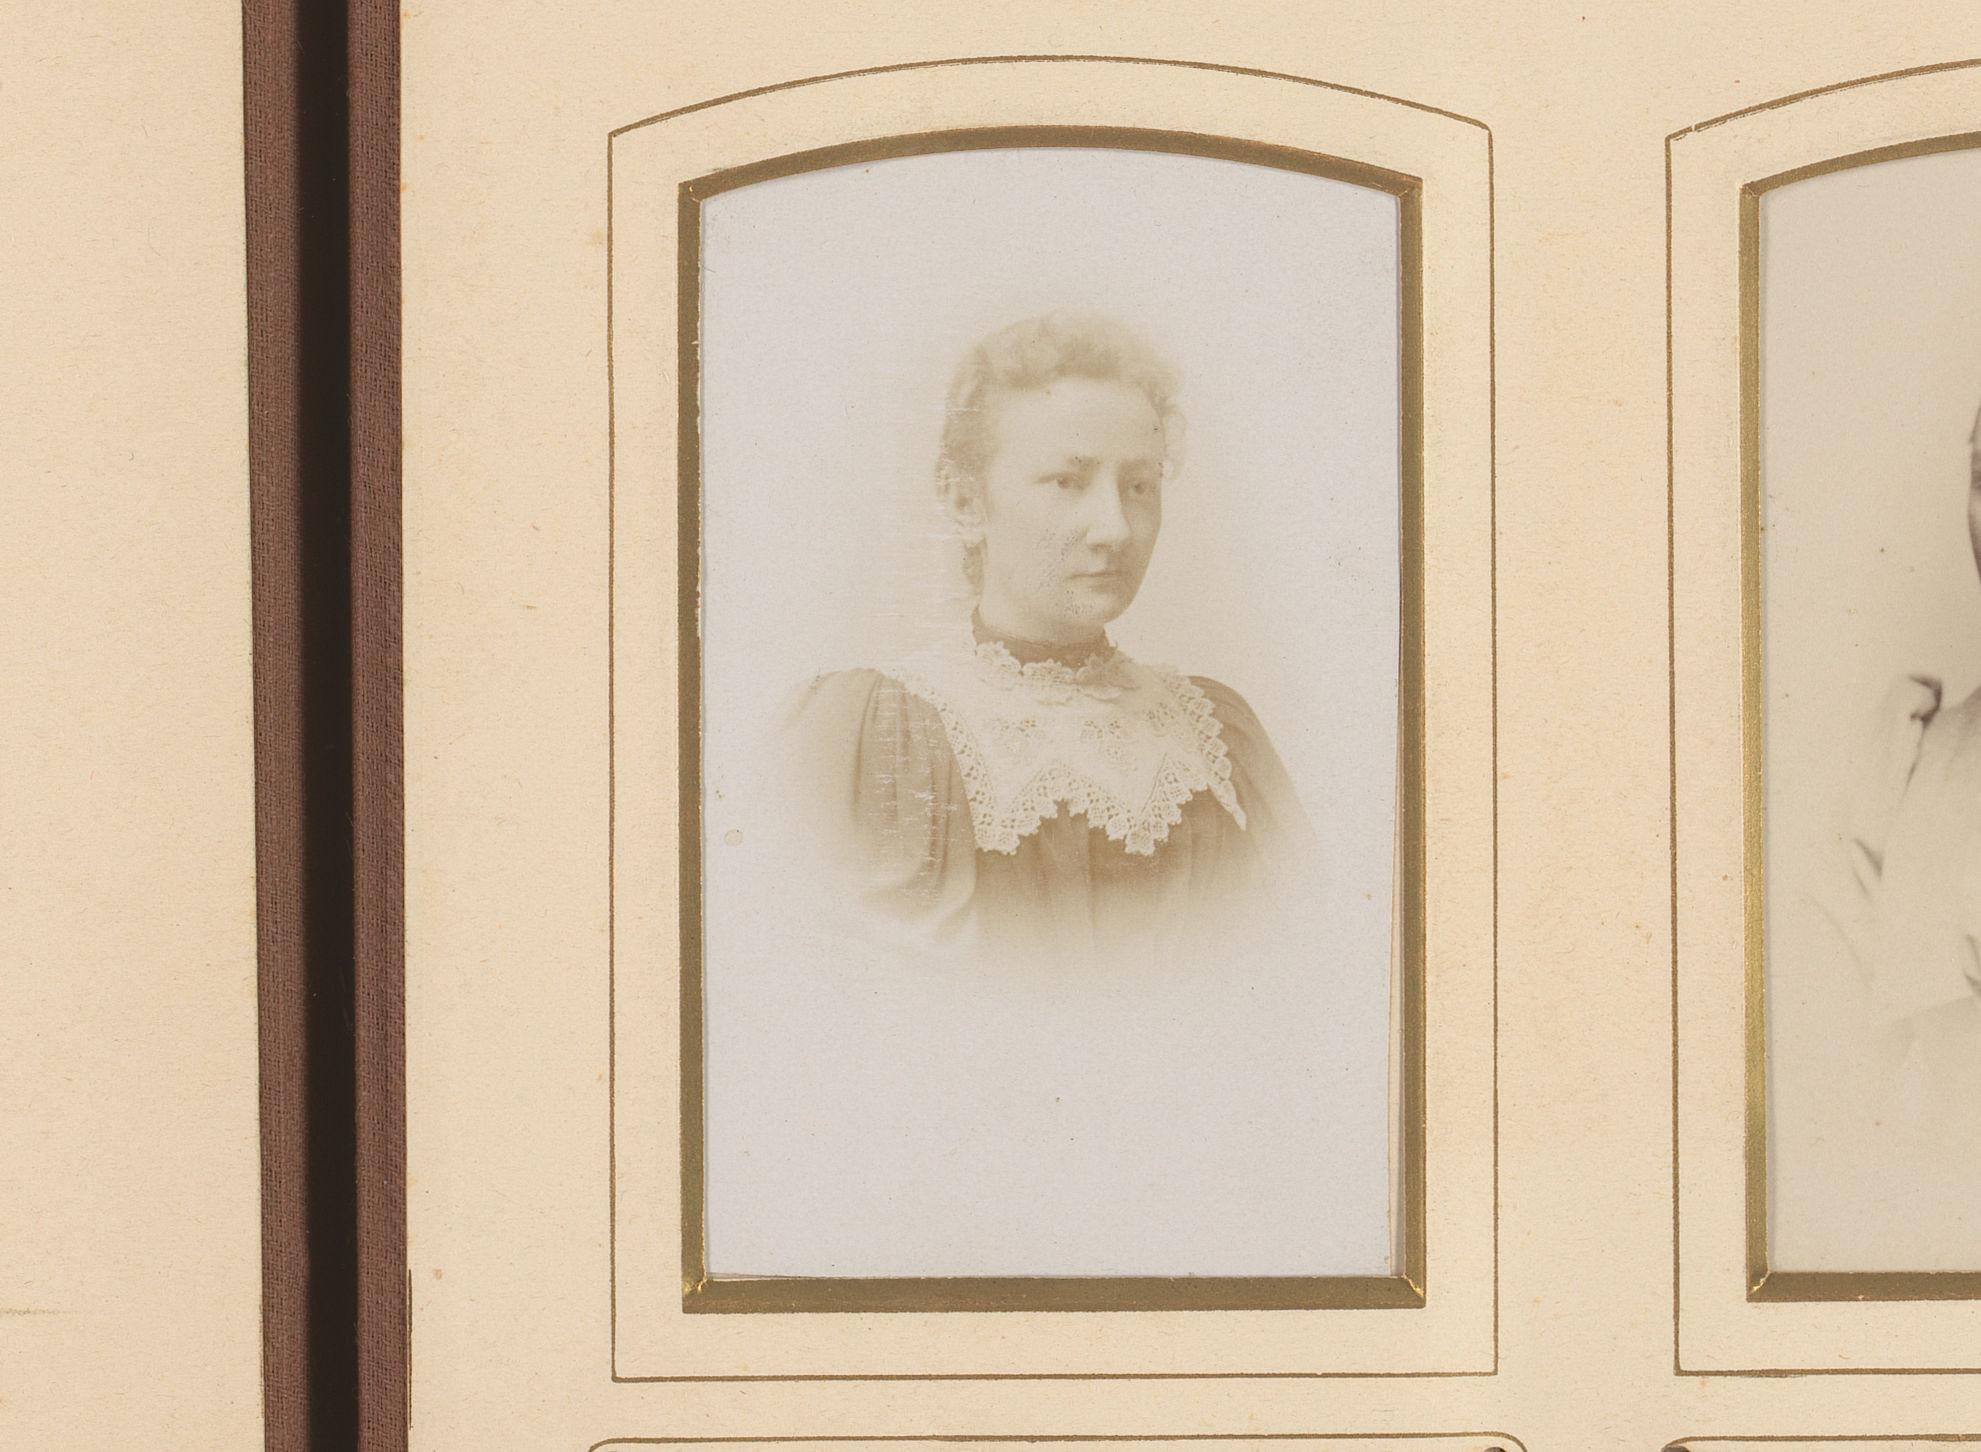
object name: photograph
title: Portret van een jonge vrouw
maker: h. van der zijl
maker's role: fotograaf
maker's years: 1852-1937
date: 1886-1908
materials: cardboard, photographic support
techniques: collodion silver print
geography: amsterdam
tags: adolescent, young woman, maiden, historical persons - bb - woman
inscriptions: inscription: ‘Photographie/ Parisienne/ H. van der Zijl/ Amsterdam/ 60 Nieuwendijk 60./ over Raamskooi en Kapelsteeg./ Gelieve op Voornaam H/ en Huisnummer 60 te Letten’